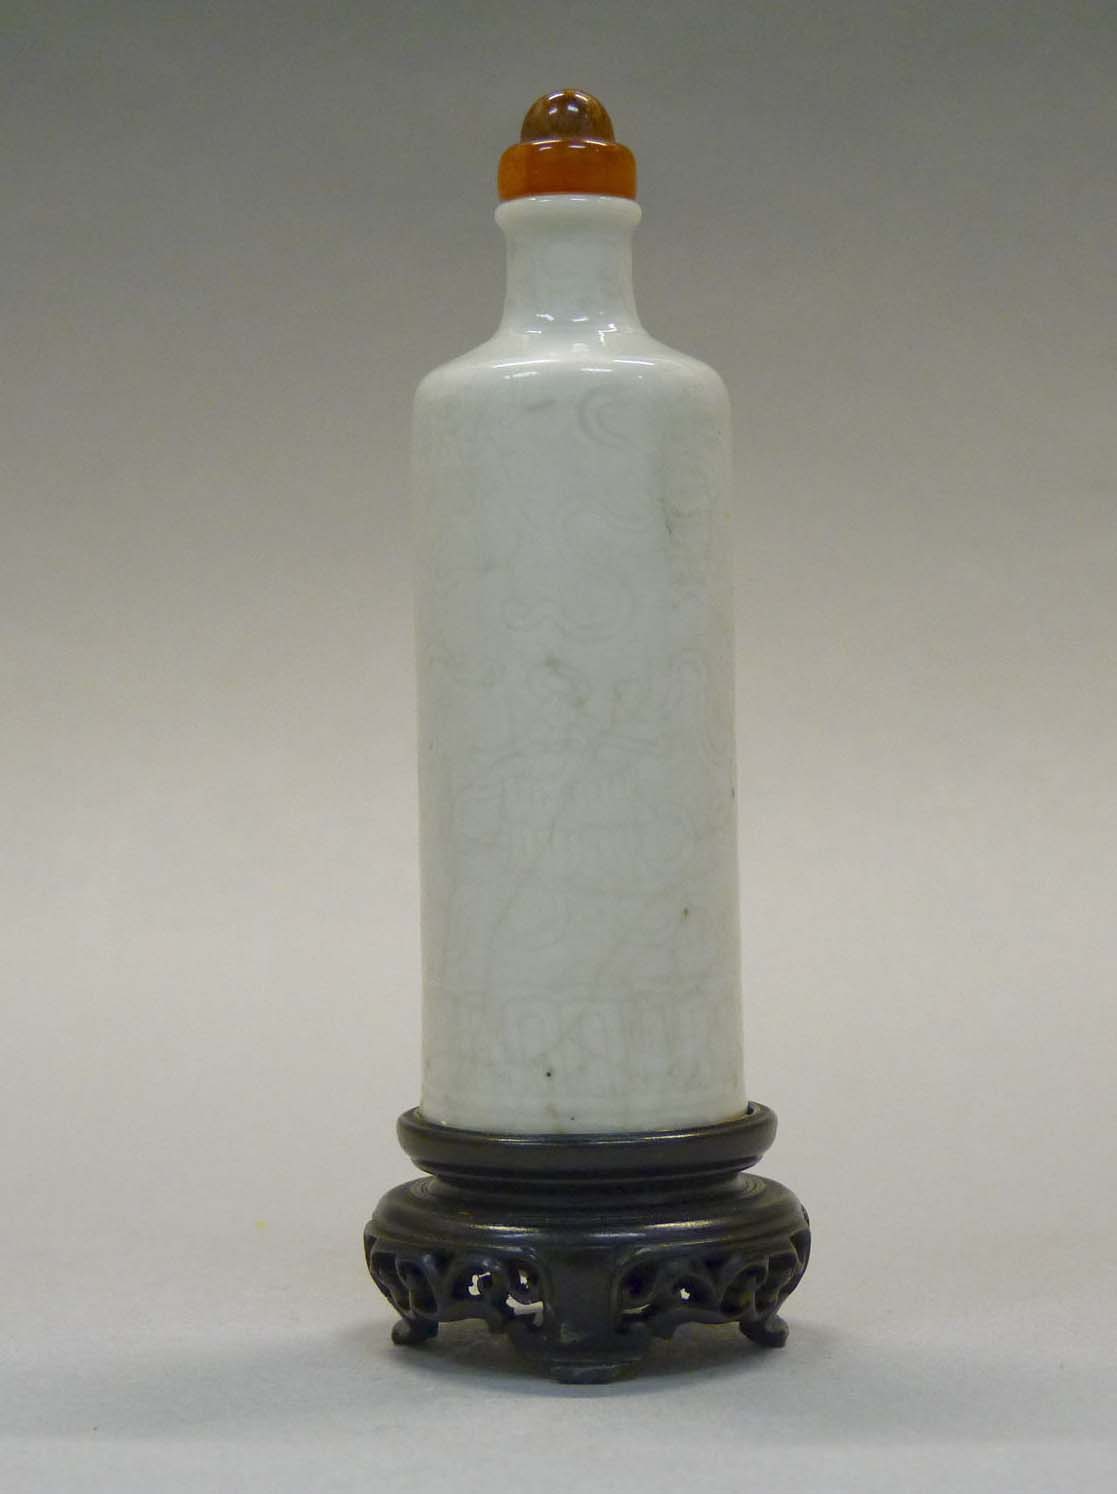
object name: snuff bottle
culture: chinese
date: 1723-1735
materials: amber, soft paste porcelain